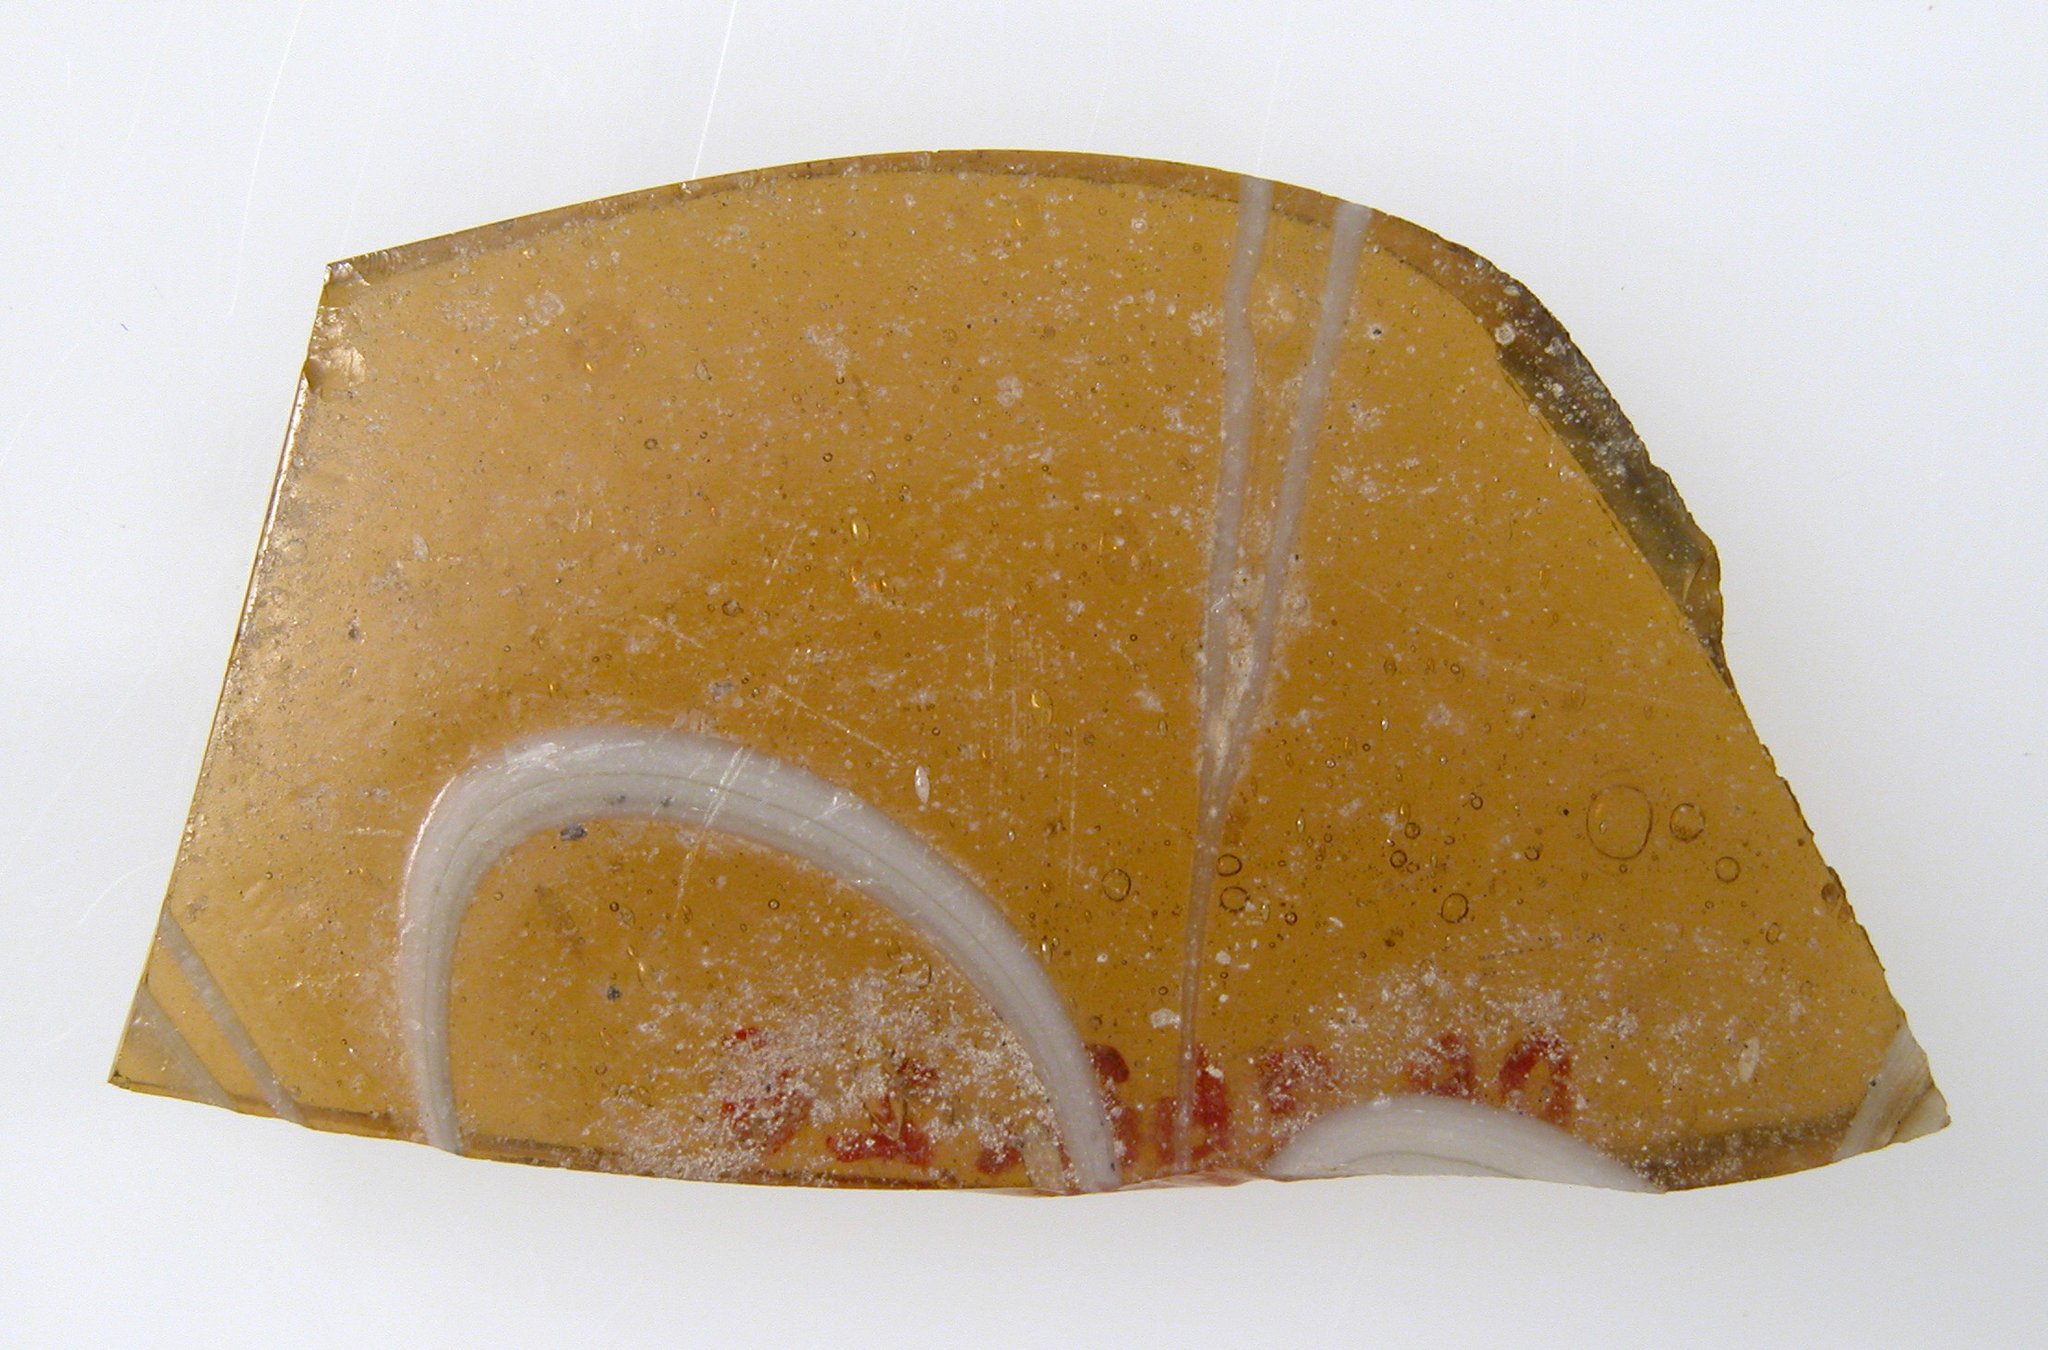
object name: fragment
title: Glass Fragment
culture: coptic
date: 301-433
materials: glass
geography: egypt